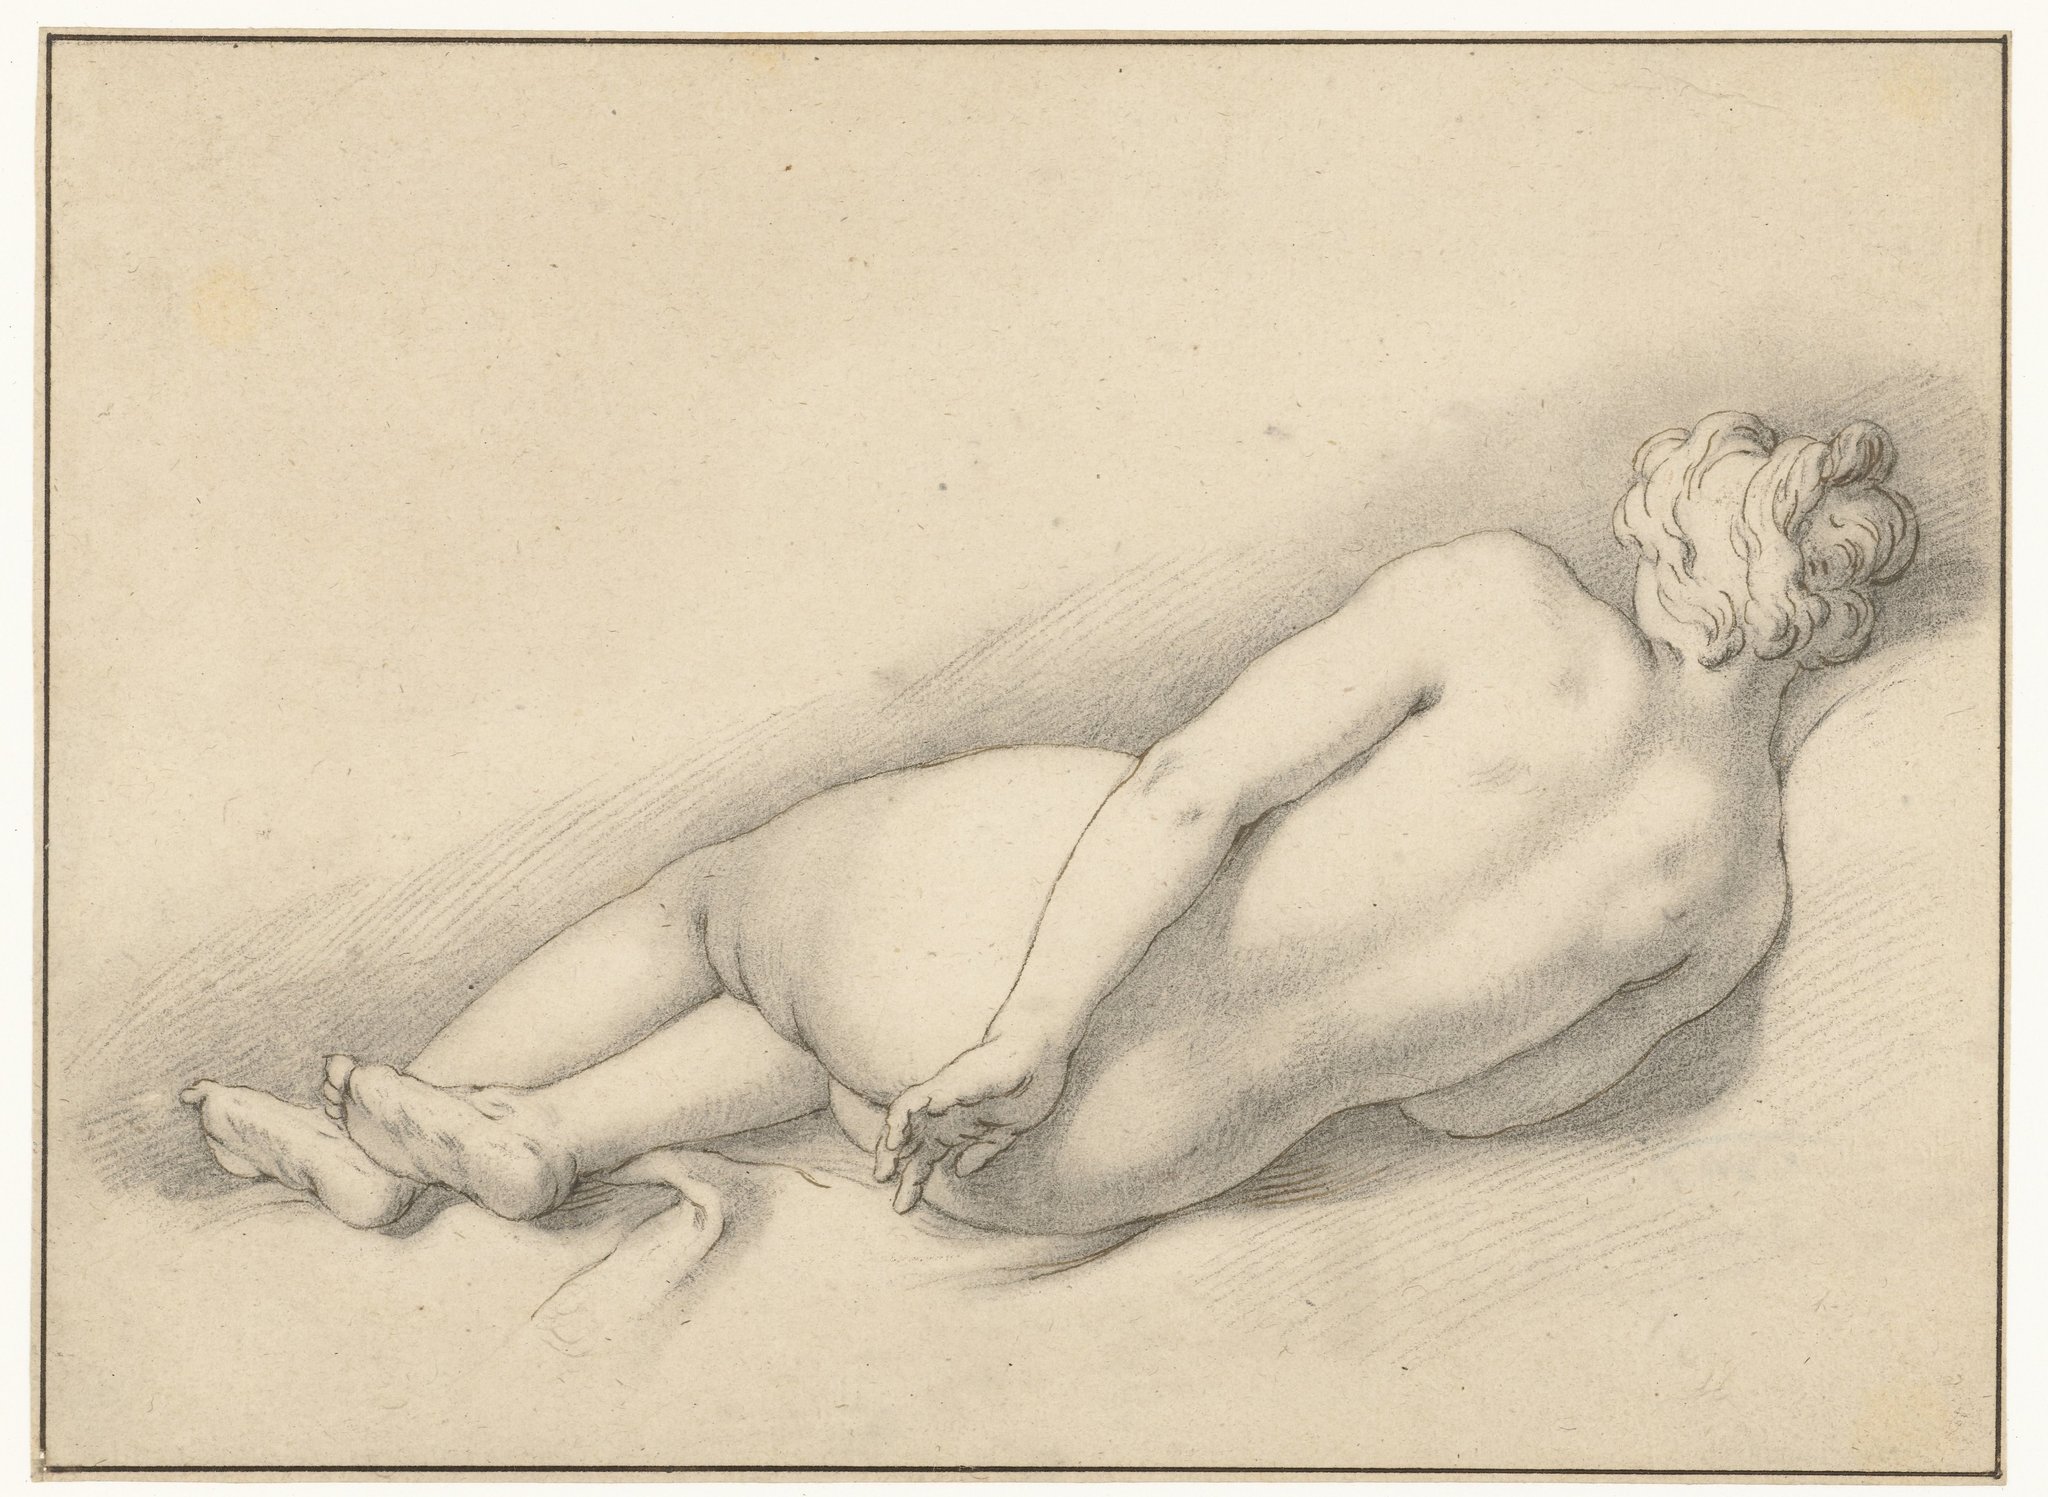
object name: drawing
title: Study of a Reclining Female Nude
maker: abraham bloemaert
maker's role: draughtsman, painter, print maker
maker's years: 1566-1651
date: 1645-1651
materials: chalk, ink, paper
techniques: pen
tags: lying figure - aa - female human figure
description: Bloemaert had more than a hundred pupils, including his four sons. To learn how to draw in their master’s style, they copied Bloemaert’s drawings. This proved so useful that Frederik Bloemaert made prints after a number of his father’s study sheets, including the one on view here. These prints were published in a model and study book for artists in training.